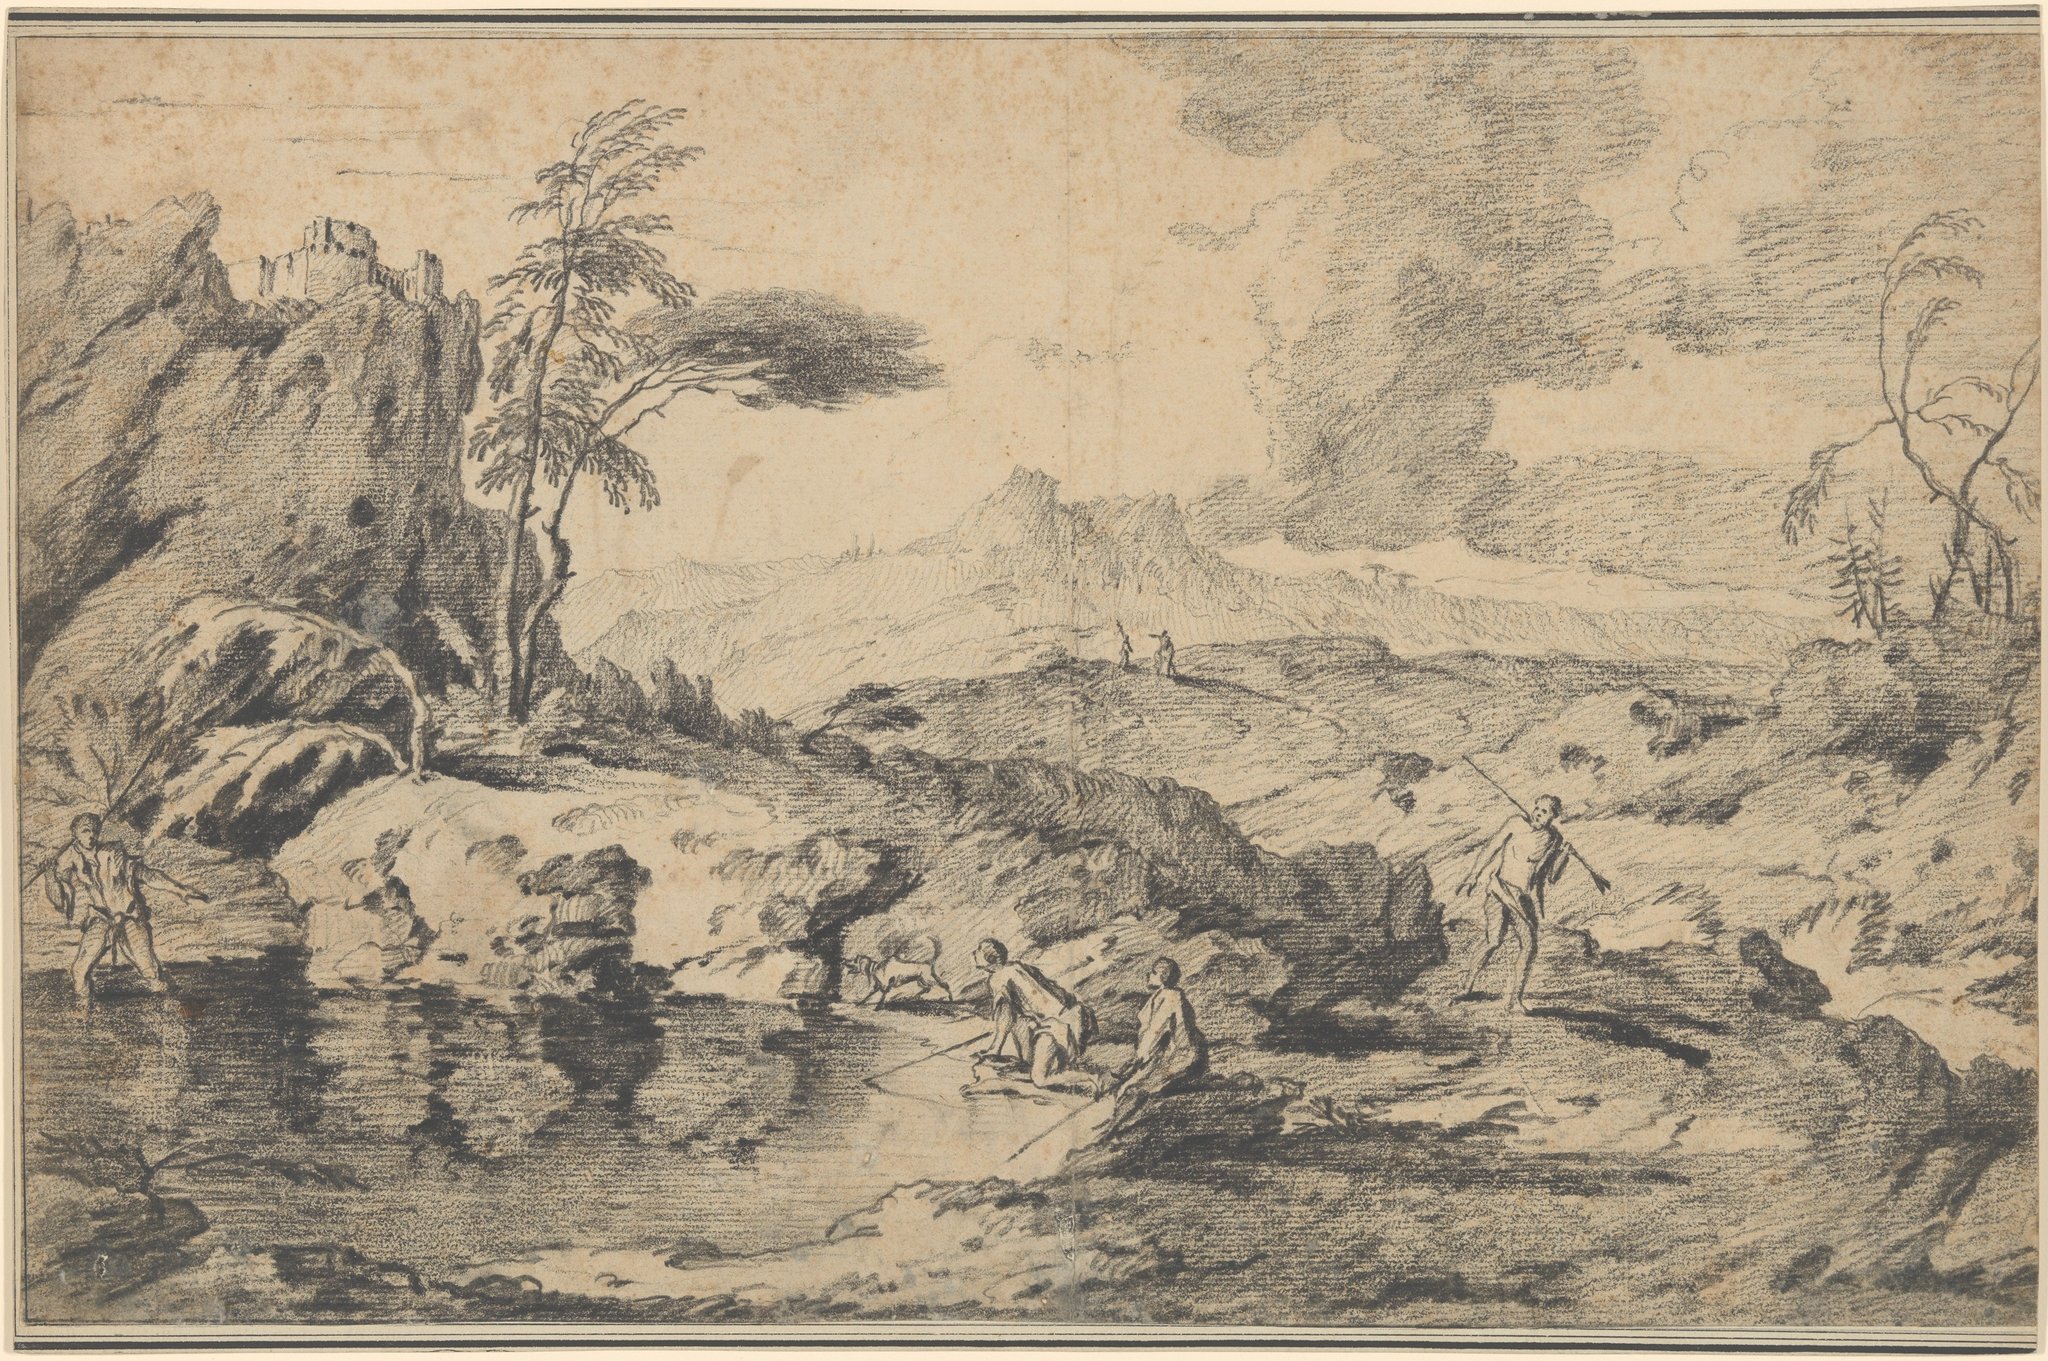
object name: drawing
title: Landscape with Fishermen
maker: gaspard dughet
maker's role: artist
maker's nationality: french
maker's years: 1615-1675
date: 1601-1700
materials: chalk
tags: men,fishing,landscapes,trees